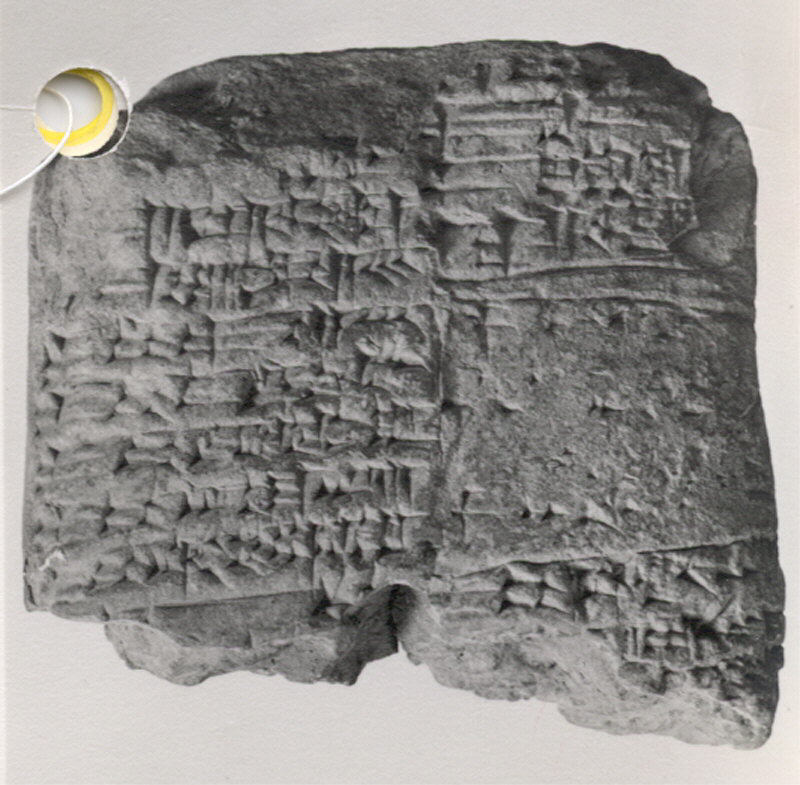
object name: cuneiform tablet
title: Cuneiform tablet: beer rations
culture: babylonian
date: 2000-1501 BCE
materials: clay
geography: mesopotamia